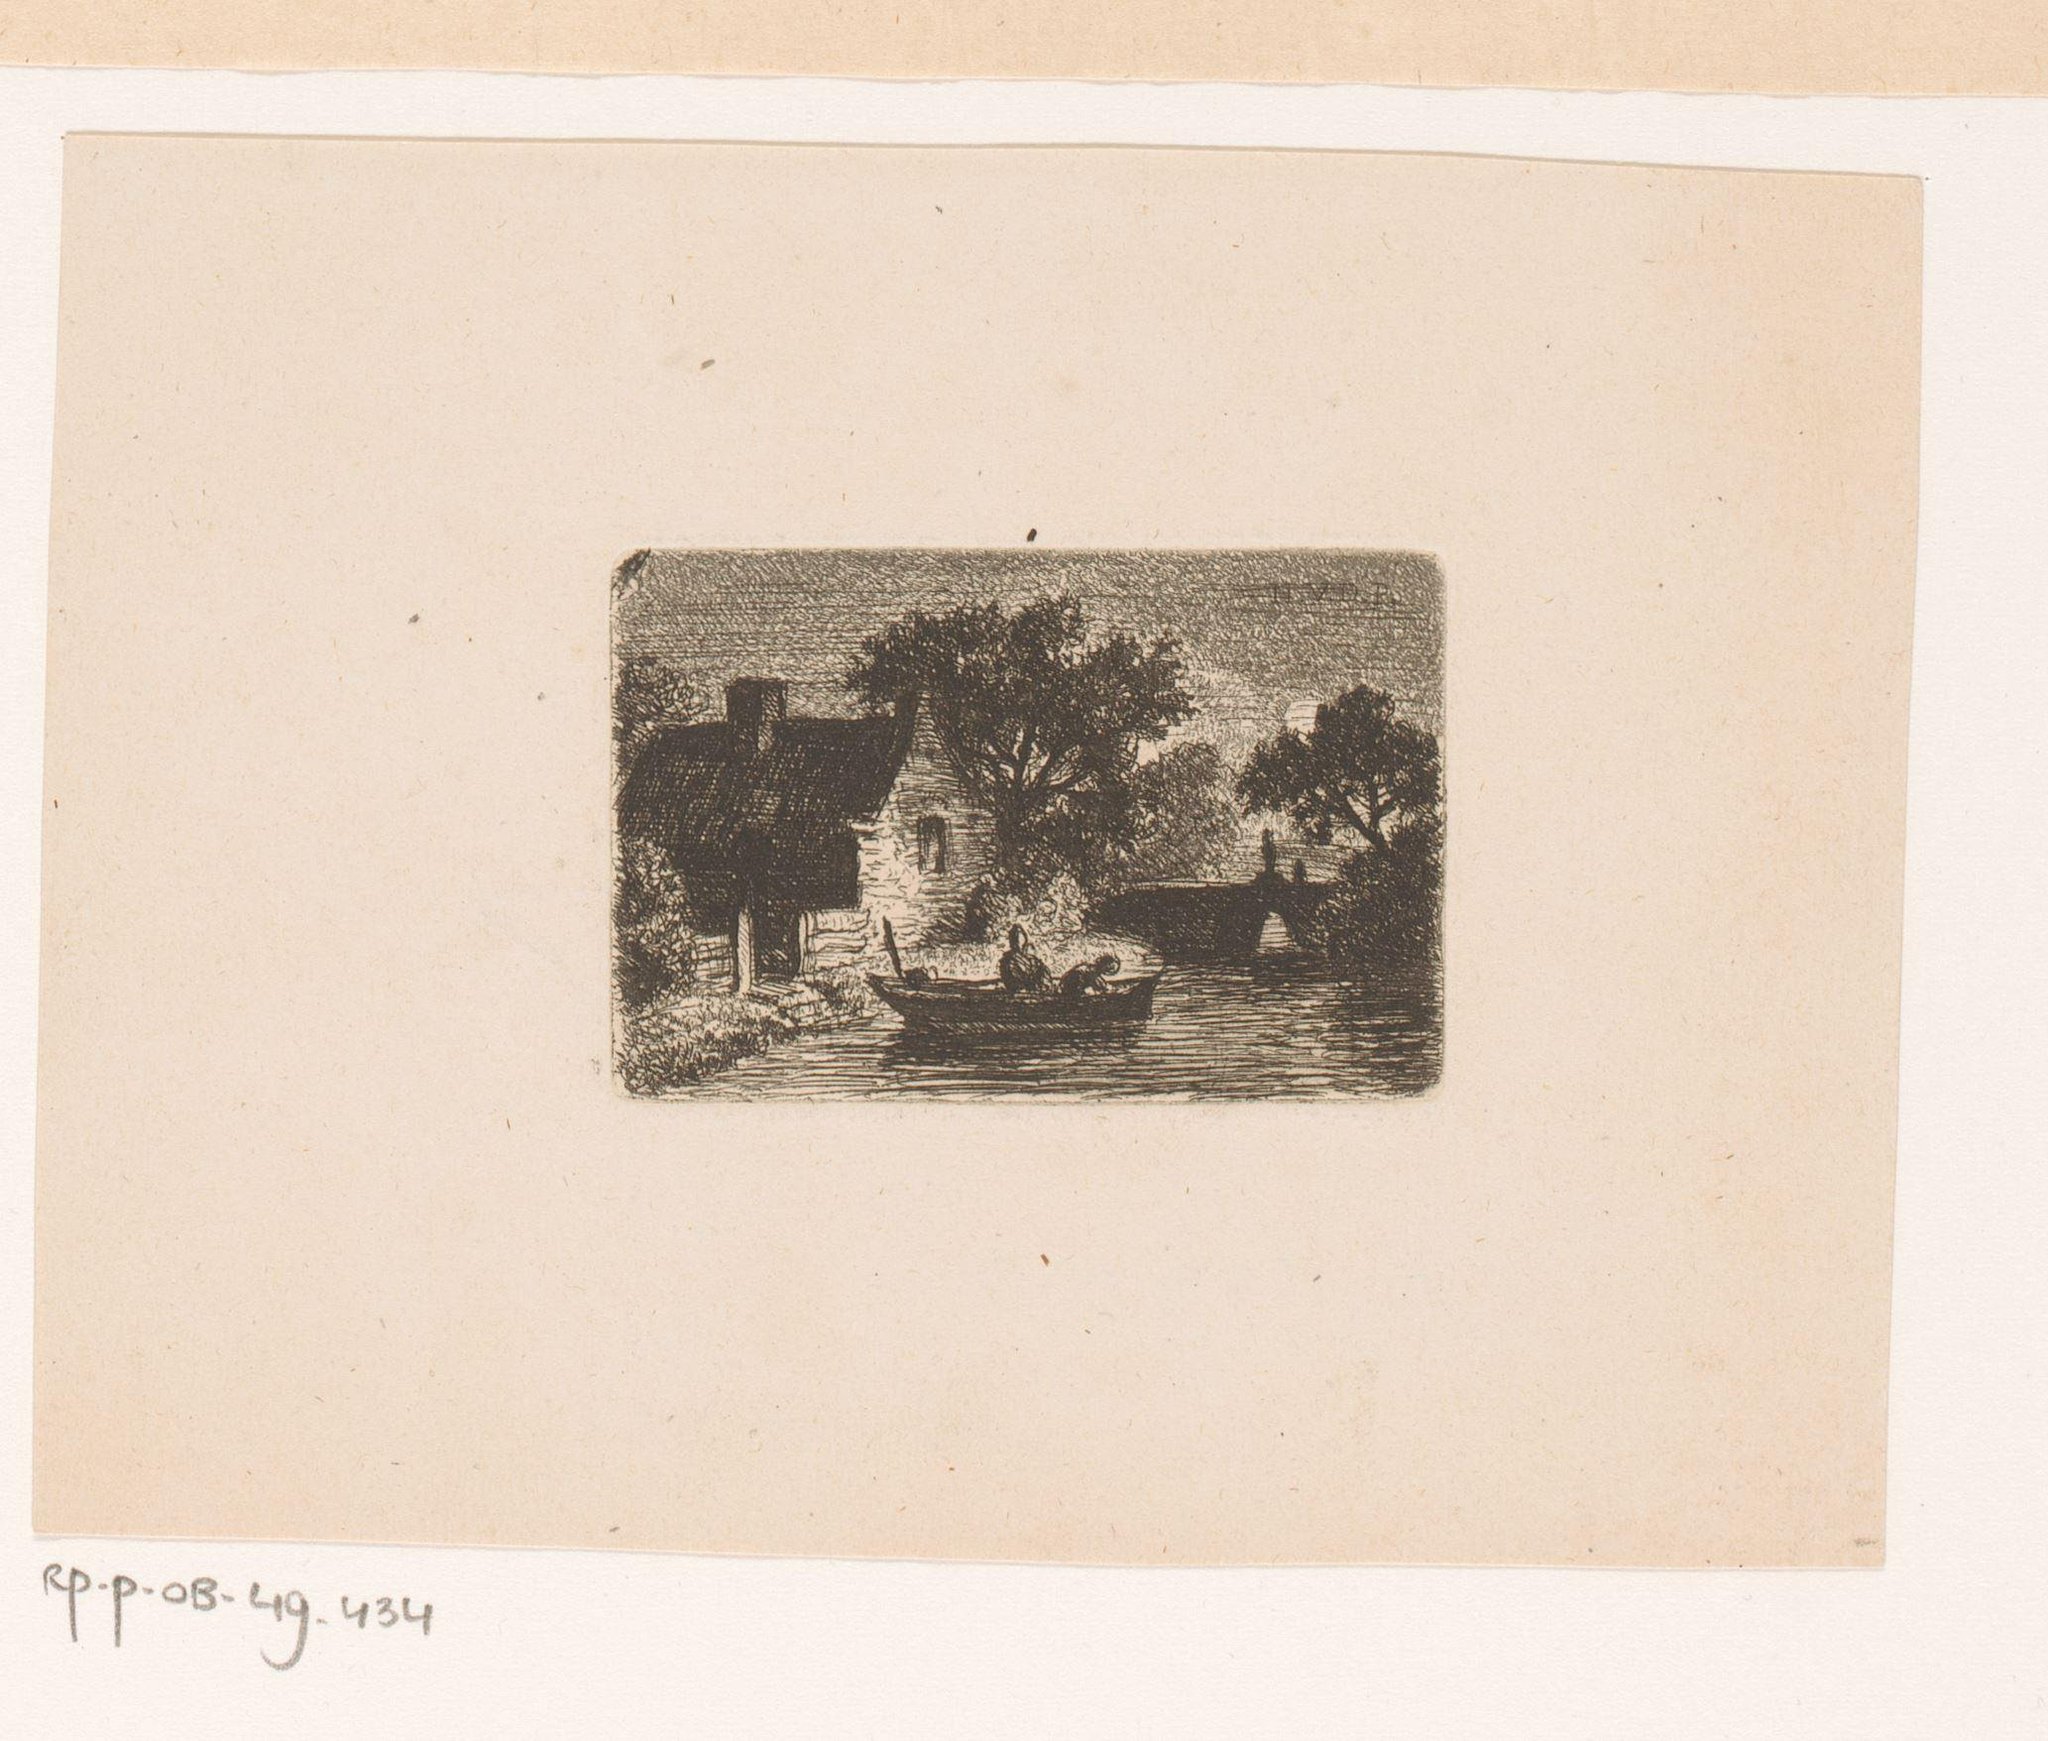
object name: print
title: Landschap met twee personen in een roeiboot bij een woning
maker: hendrik jozef franciscus van der poorten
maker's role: draughtsman, print maker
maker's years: 1789-1874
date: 1799-1874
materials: paper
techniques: etching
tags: rowing-boat, canoe, etc., bridge in village across river, canal, etc.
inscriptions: collector's mark: Lugt 2228